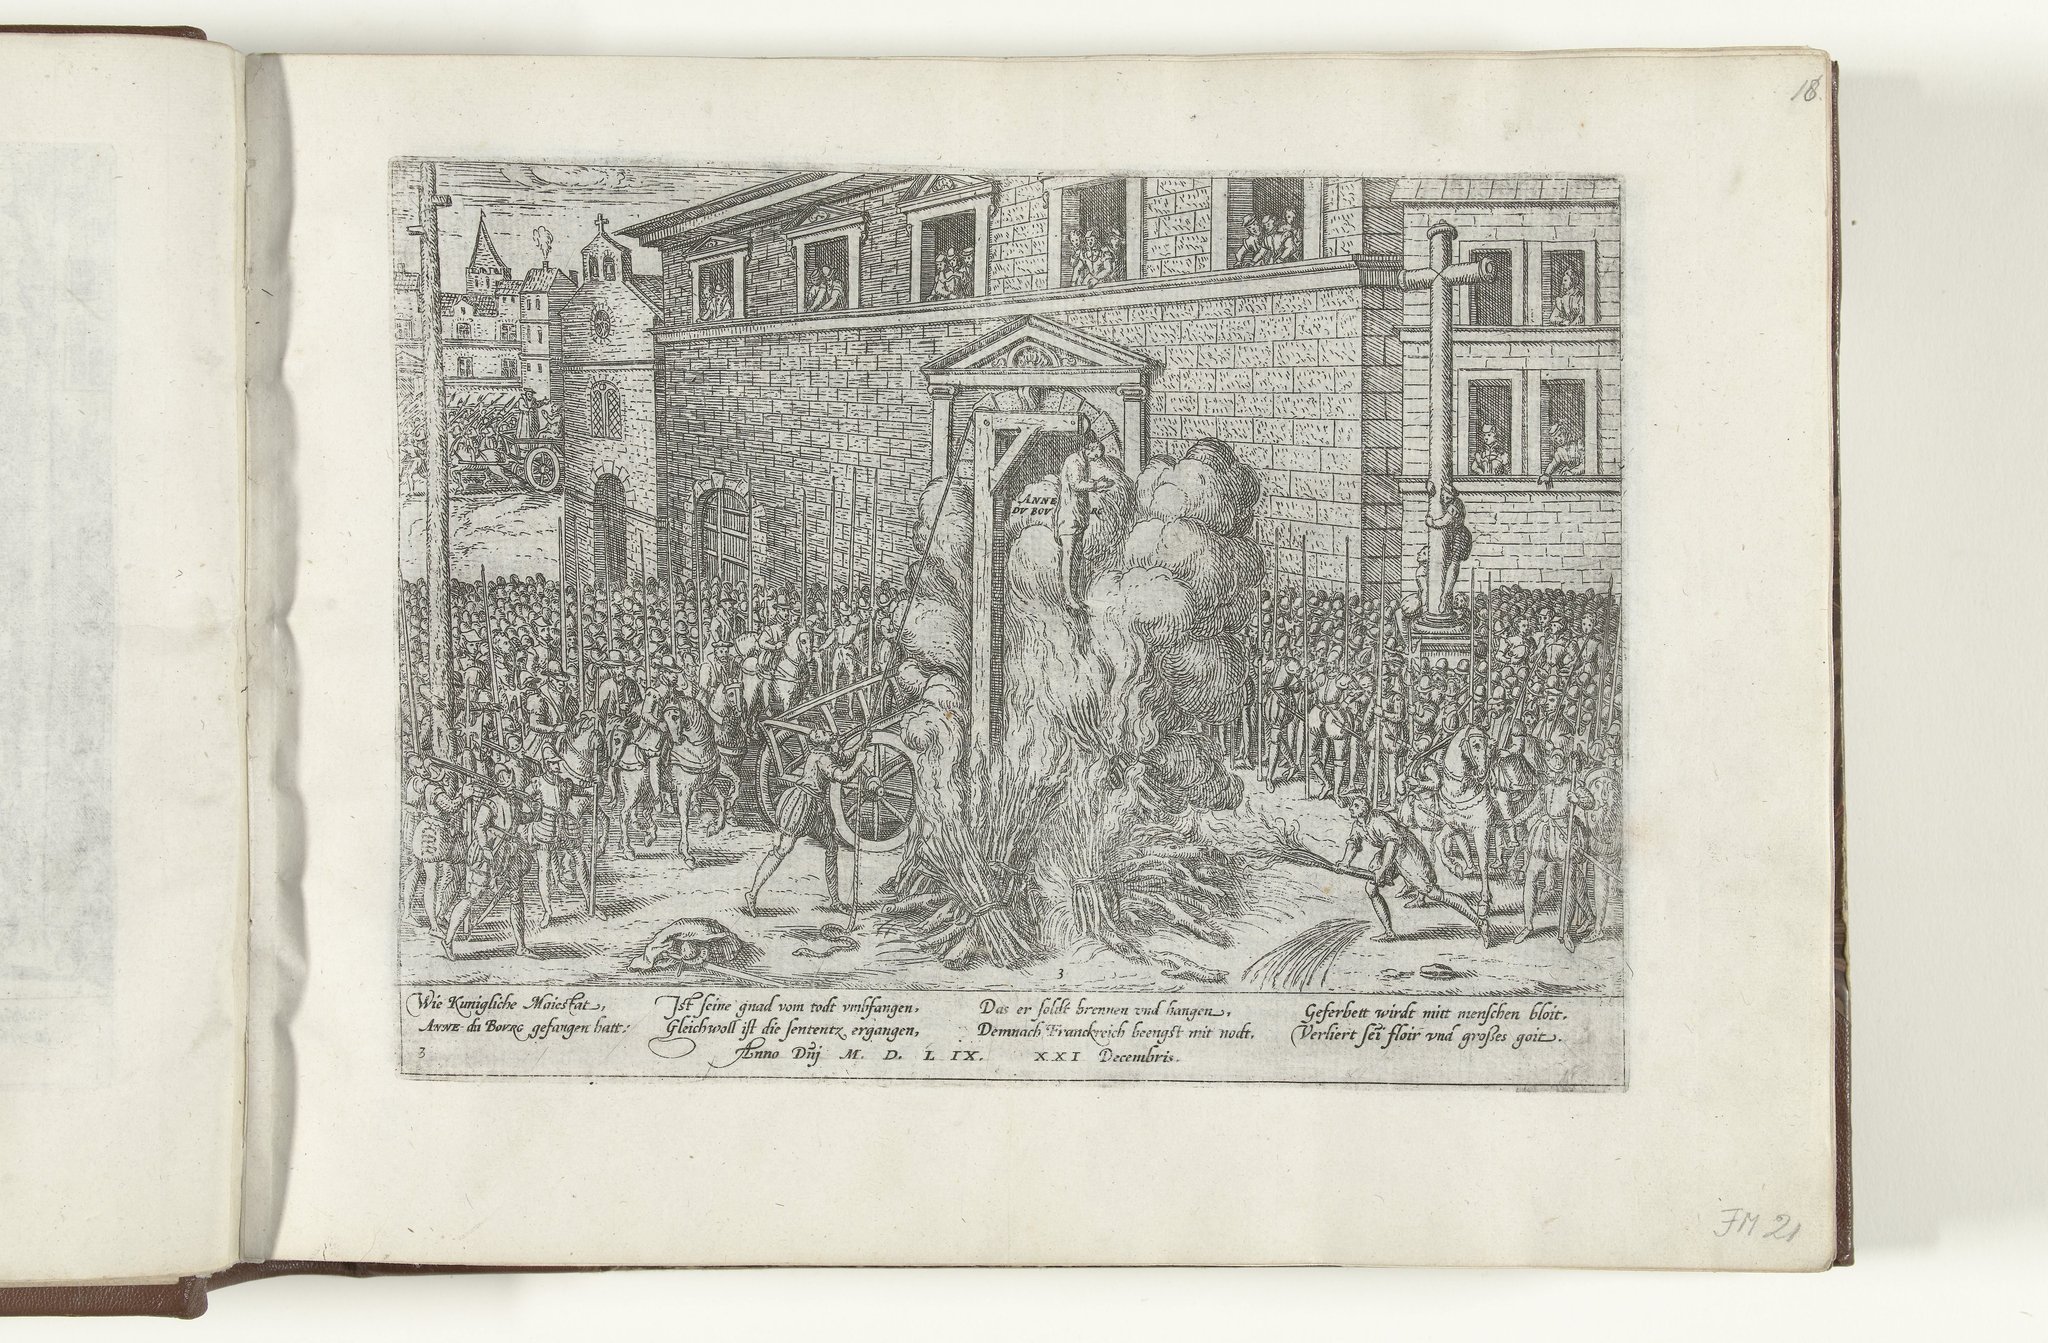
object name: history print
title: Serie 3: Franse Godsdienstoorlogen, 1559-1573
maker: frans hogenberg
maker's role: print maker, publisher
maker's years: 1538-1590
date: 1565-1573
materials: paper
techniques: etching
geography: cologne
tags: paris, violent death by burning at the stake; pyre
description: Gekopieerd naar de prent in: Jean Tortorel et Jacques Perrissin, Premier volume contenant quarante tableaux ou Histoires diverses qui sont memorables touchant les Guerres, Massacres et Troubles advenus en France en ces dernieres annees : le tout recueilly selon le tesmoignange de ceux qui y ont esté en personne et qui les ont veus : lesquels sont pourtraits à la vérité, Genève ca. 1570. Bibliotheek Rijksmuseum: 329 A 2, pl. 5.